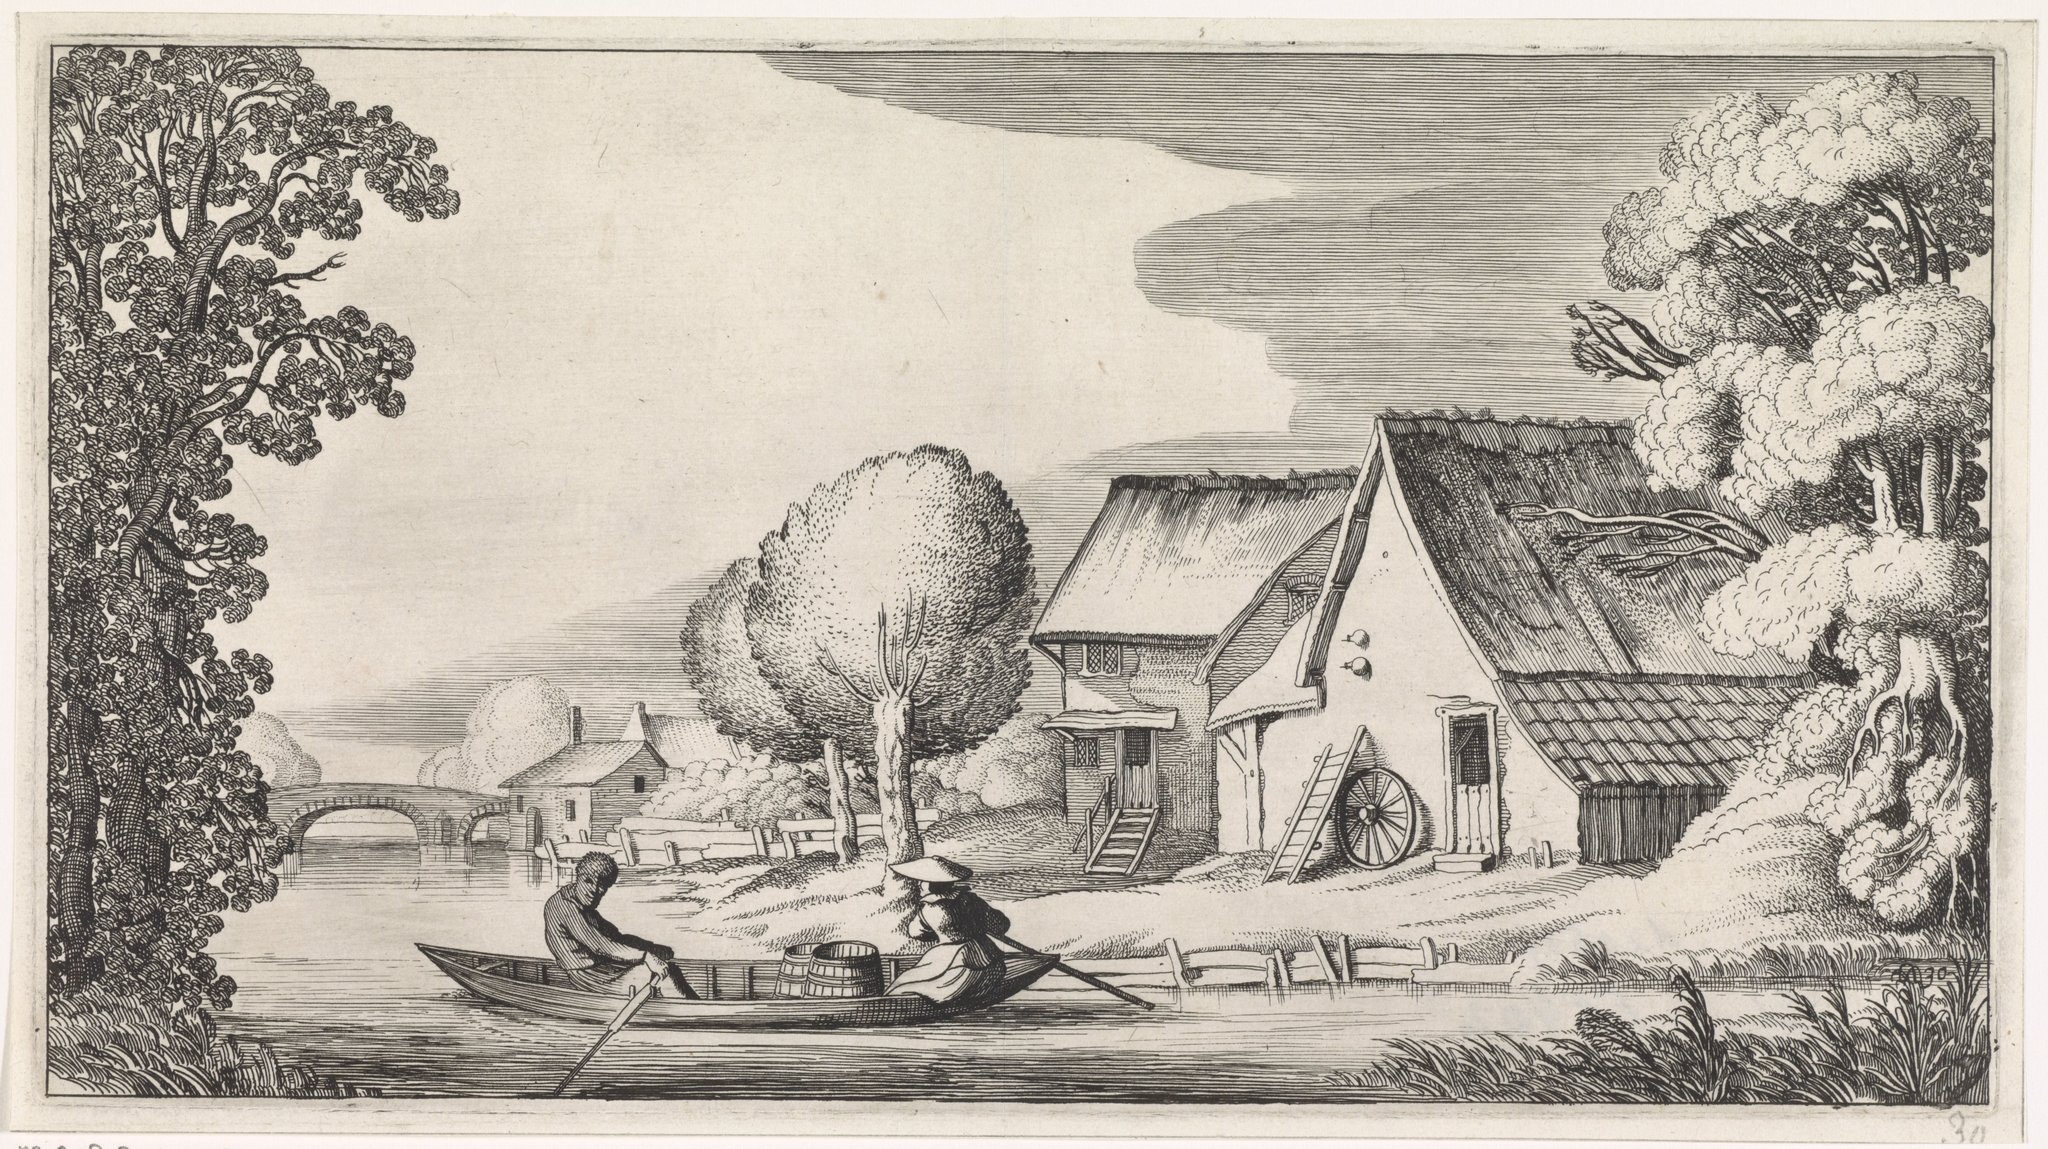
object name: print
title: Boer en boerin in een roeiboot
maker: jan van de velde (ii)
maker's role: draughtsman, painter, print maker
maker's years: 1593-1641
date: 1639-1641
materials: paper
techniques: etching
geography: northern netherlands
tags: wooden container: barrel, cask, bucket, river, landscape with bridge, viaduct or aqueduct, rowing-boat, canoe, etc., farm (building)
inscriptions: collector's mark: Lugt 964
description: Boer en boerin in een roeiboot waarin twee tonnen, op een rivier langs een boerderij. Op de achtergrond een stenen brug. 30ste prent van een serie met 36 prenten van landschappen, verdeeld over zes delen.